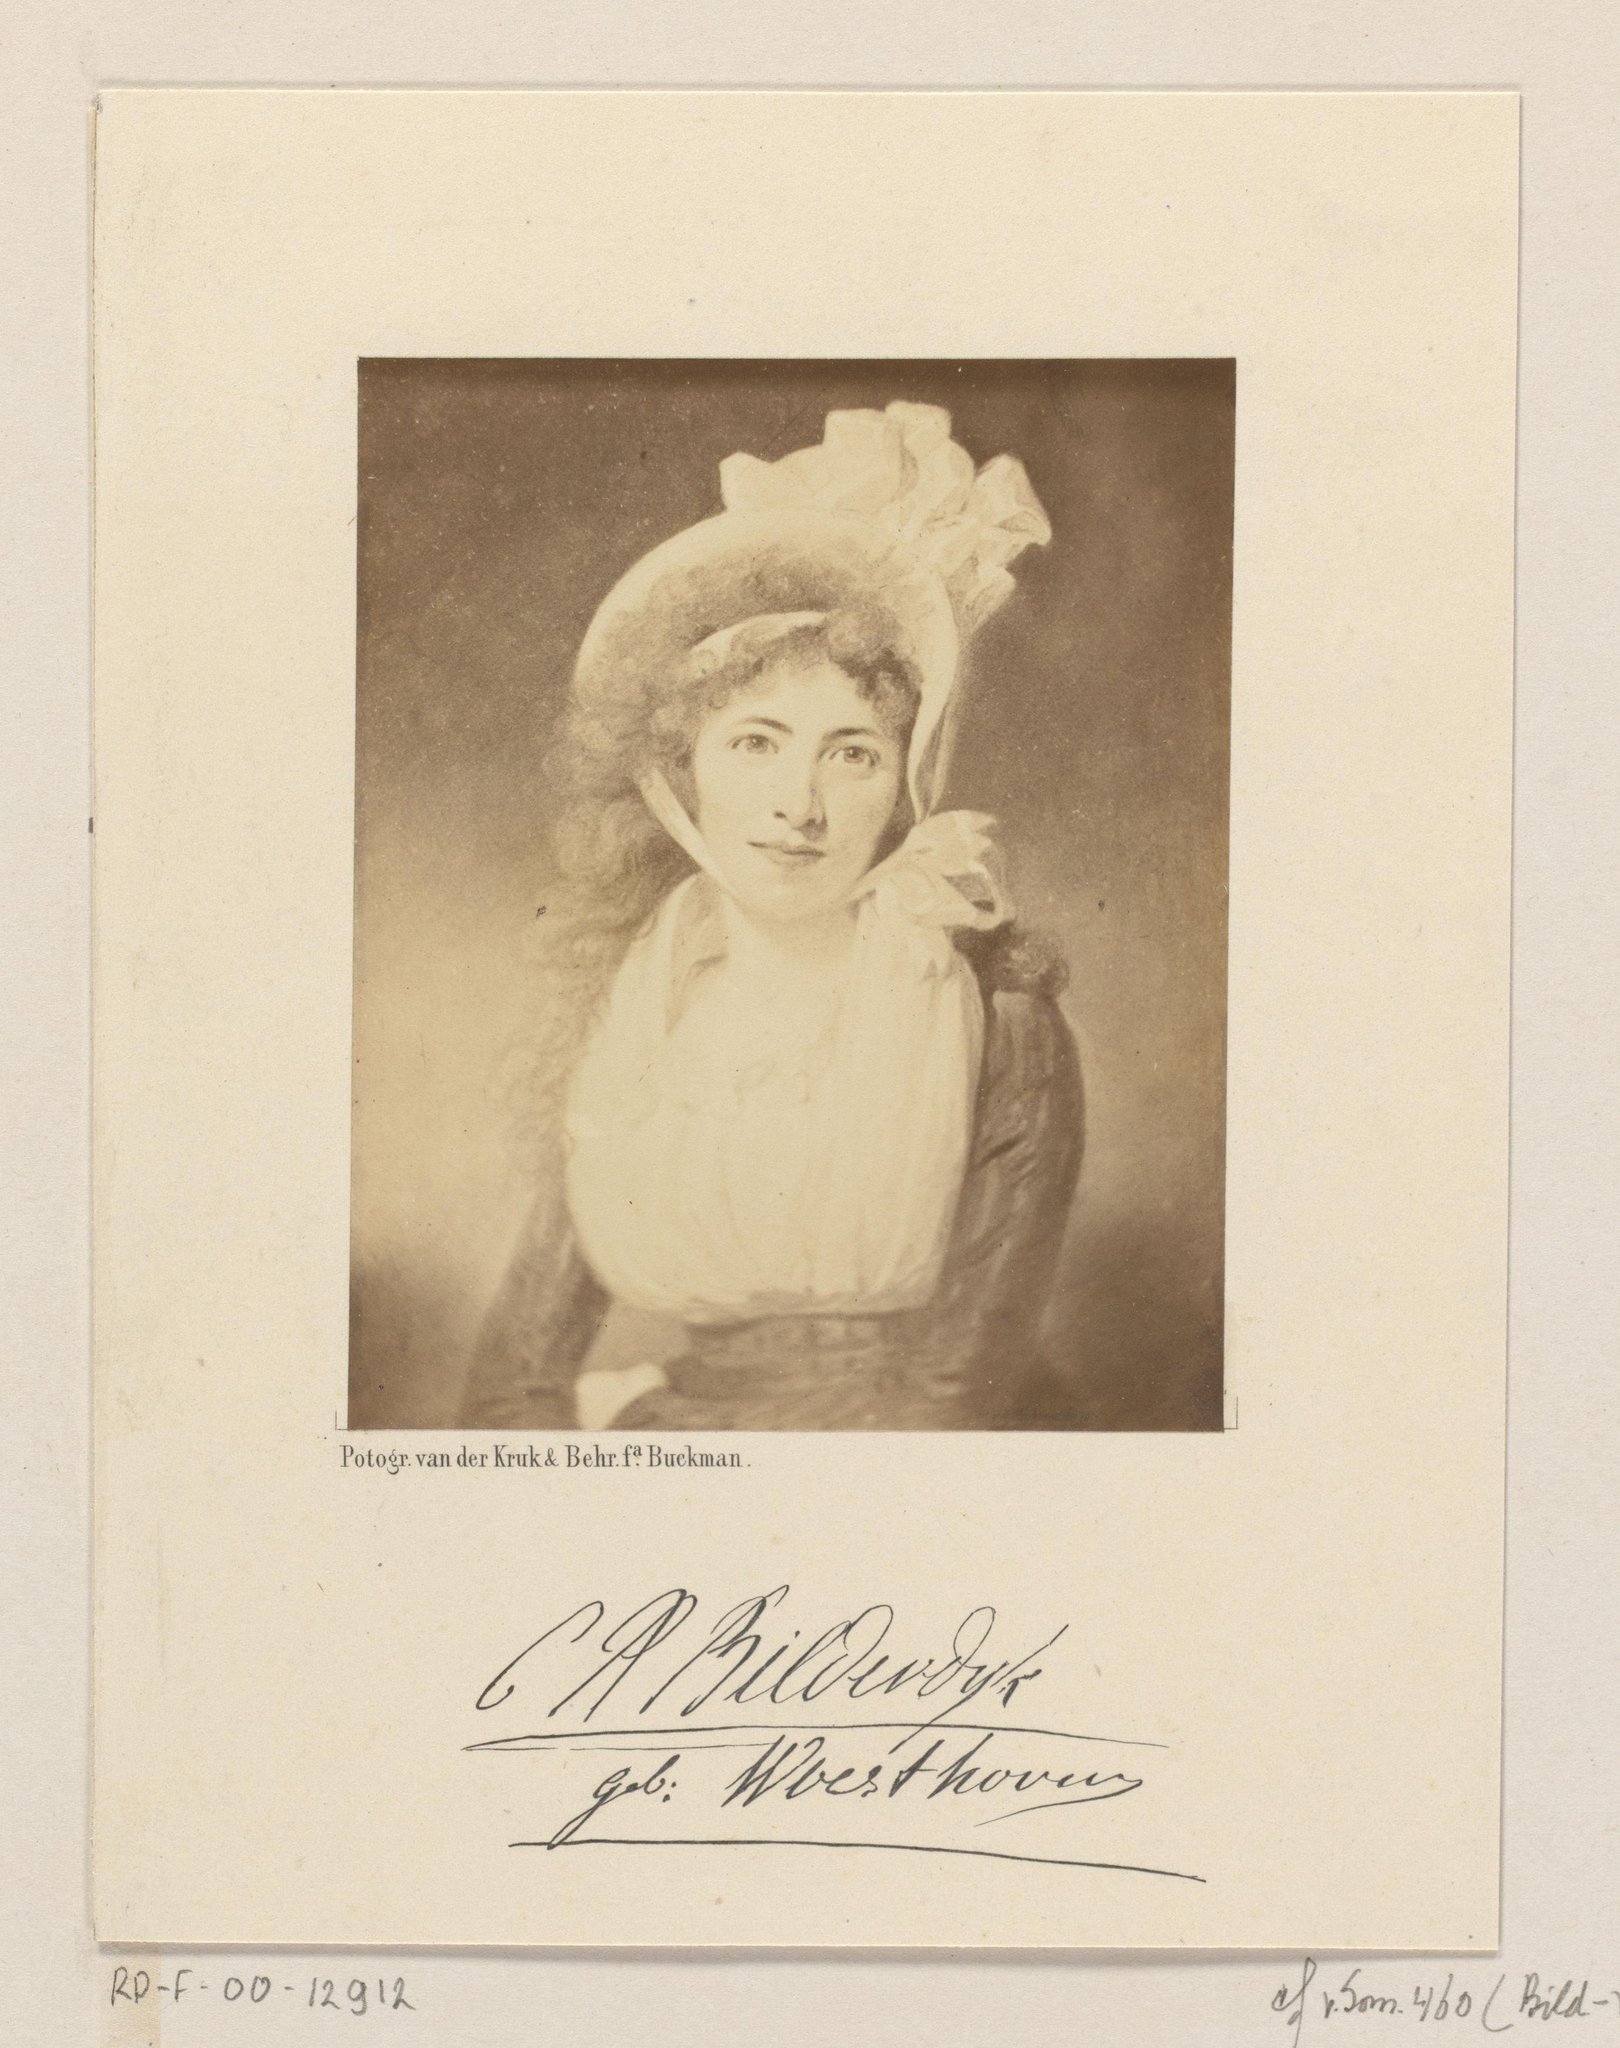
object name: reproduction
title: Fotoreproductie van een geschilderd portret van Catharina Rebecca Woesthoven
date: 1851-1900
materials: cardboard, paper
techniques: albumen print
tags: amsterdam, historical persons - bb - woman, picture, painting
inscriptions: inscription: ‘CA Bilderdijk/ geb: Westhoven’